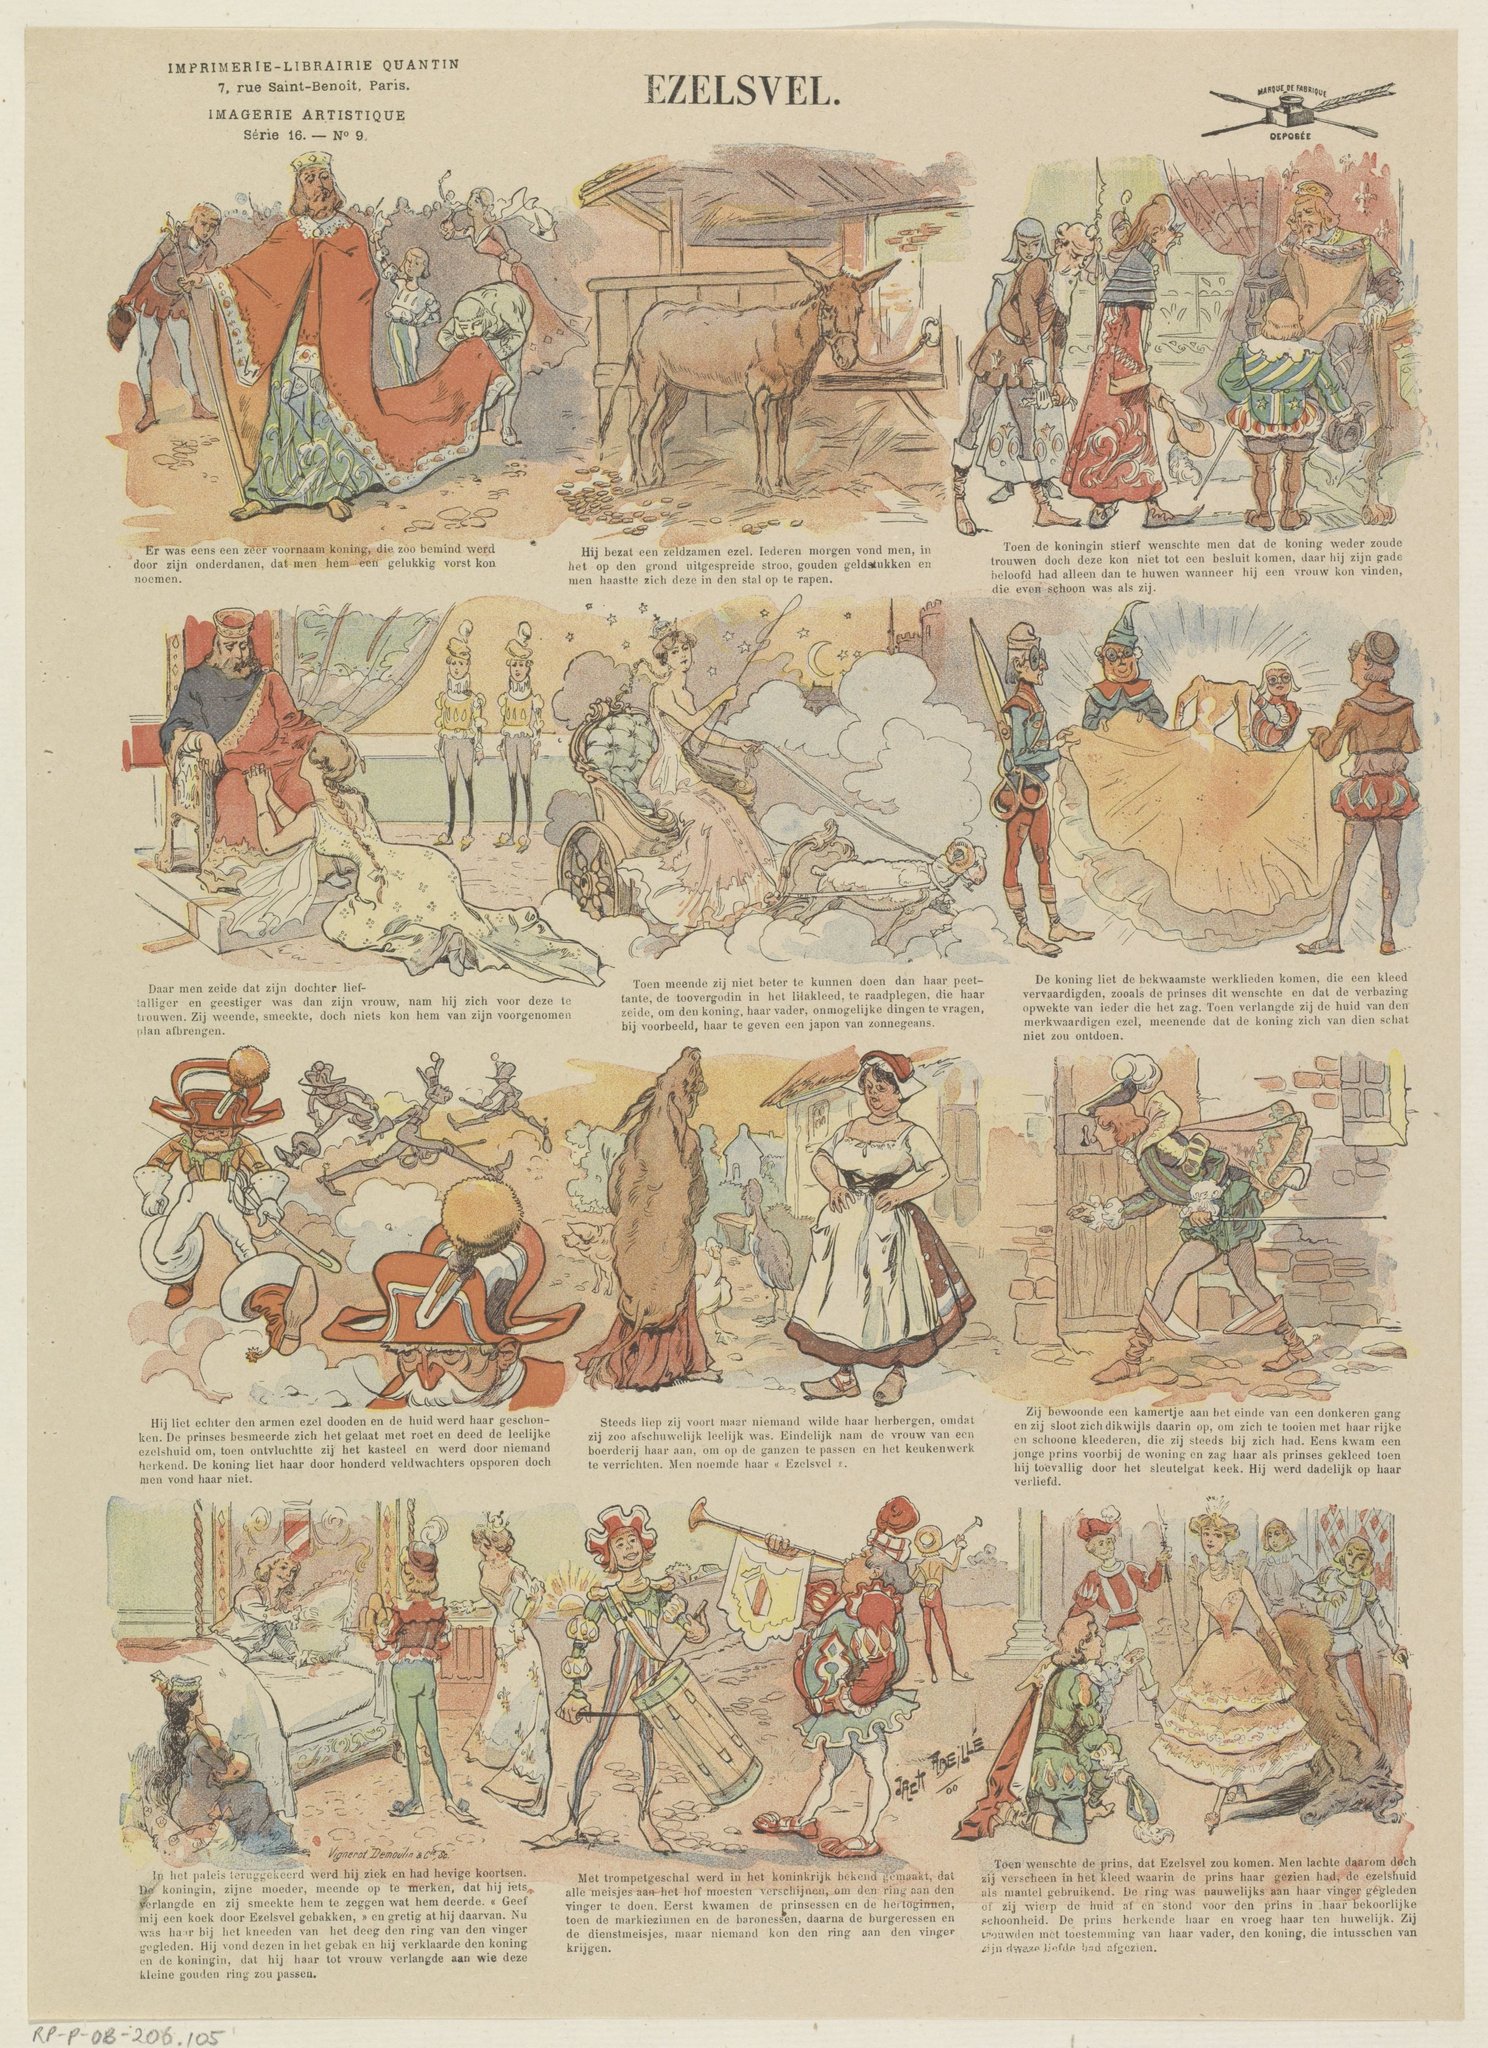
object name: print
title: Ezelsvel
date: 1876-1890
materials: paper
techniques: lithograph, letterpress printing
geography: paris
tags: ass, donkey, tales and fairy tales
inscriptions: collector's mark: Lugt 2760, : ‘marque de fabrique / deposée’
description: Blad met 12 voorstellingen uit het sprookje van Ezelsvel. Onder elke afbeelding een onderschrift. Genummerd linksboven: Série 16. - No. 9.